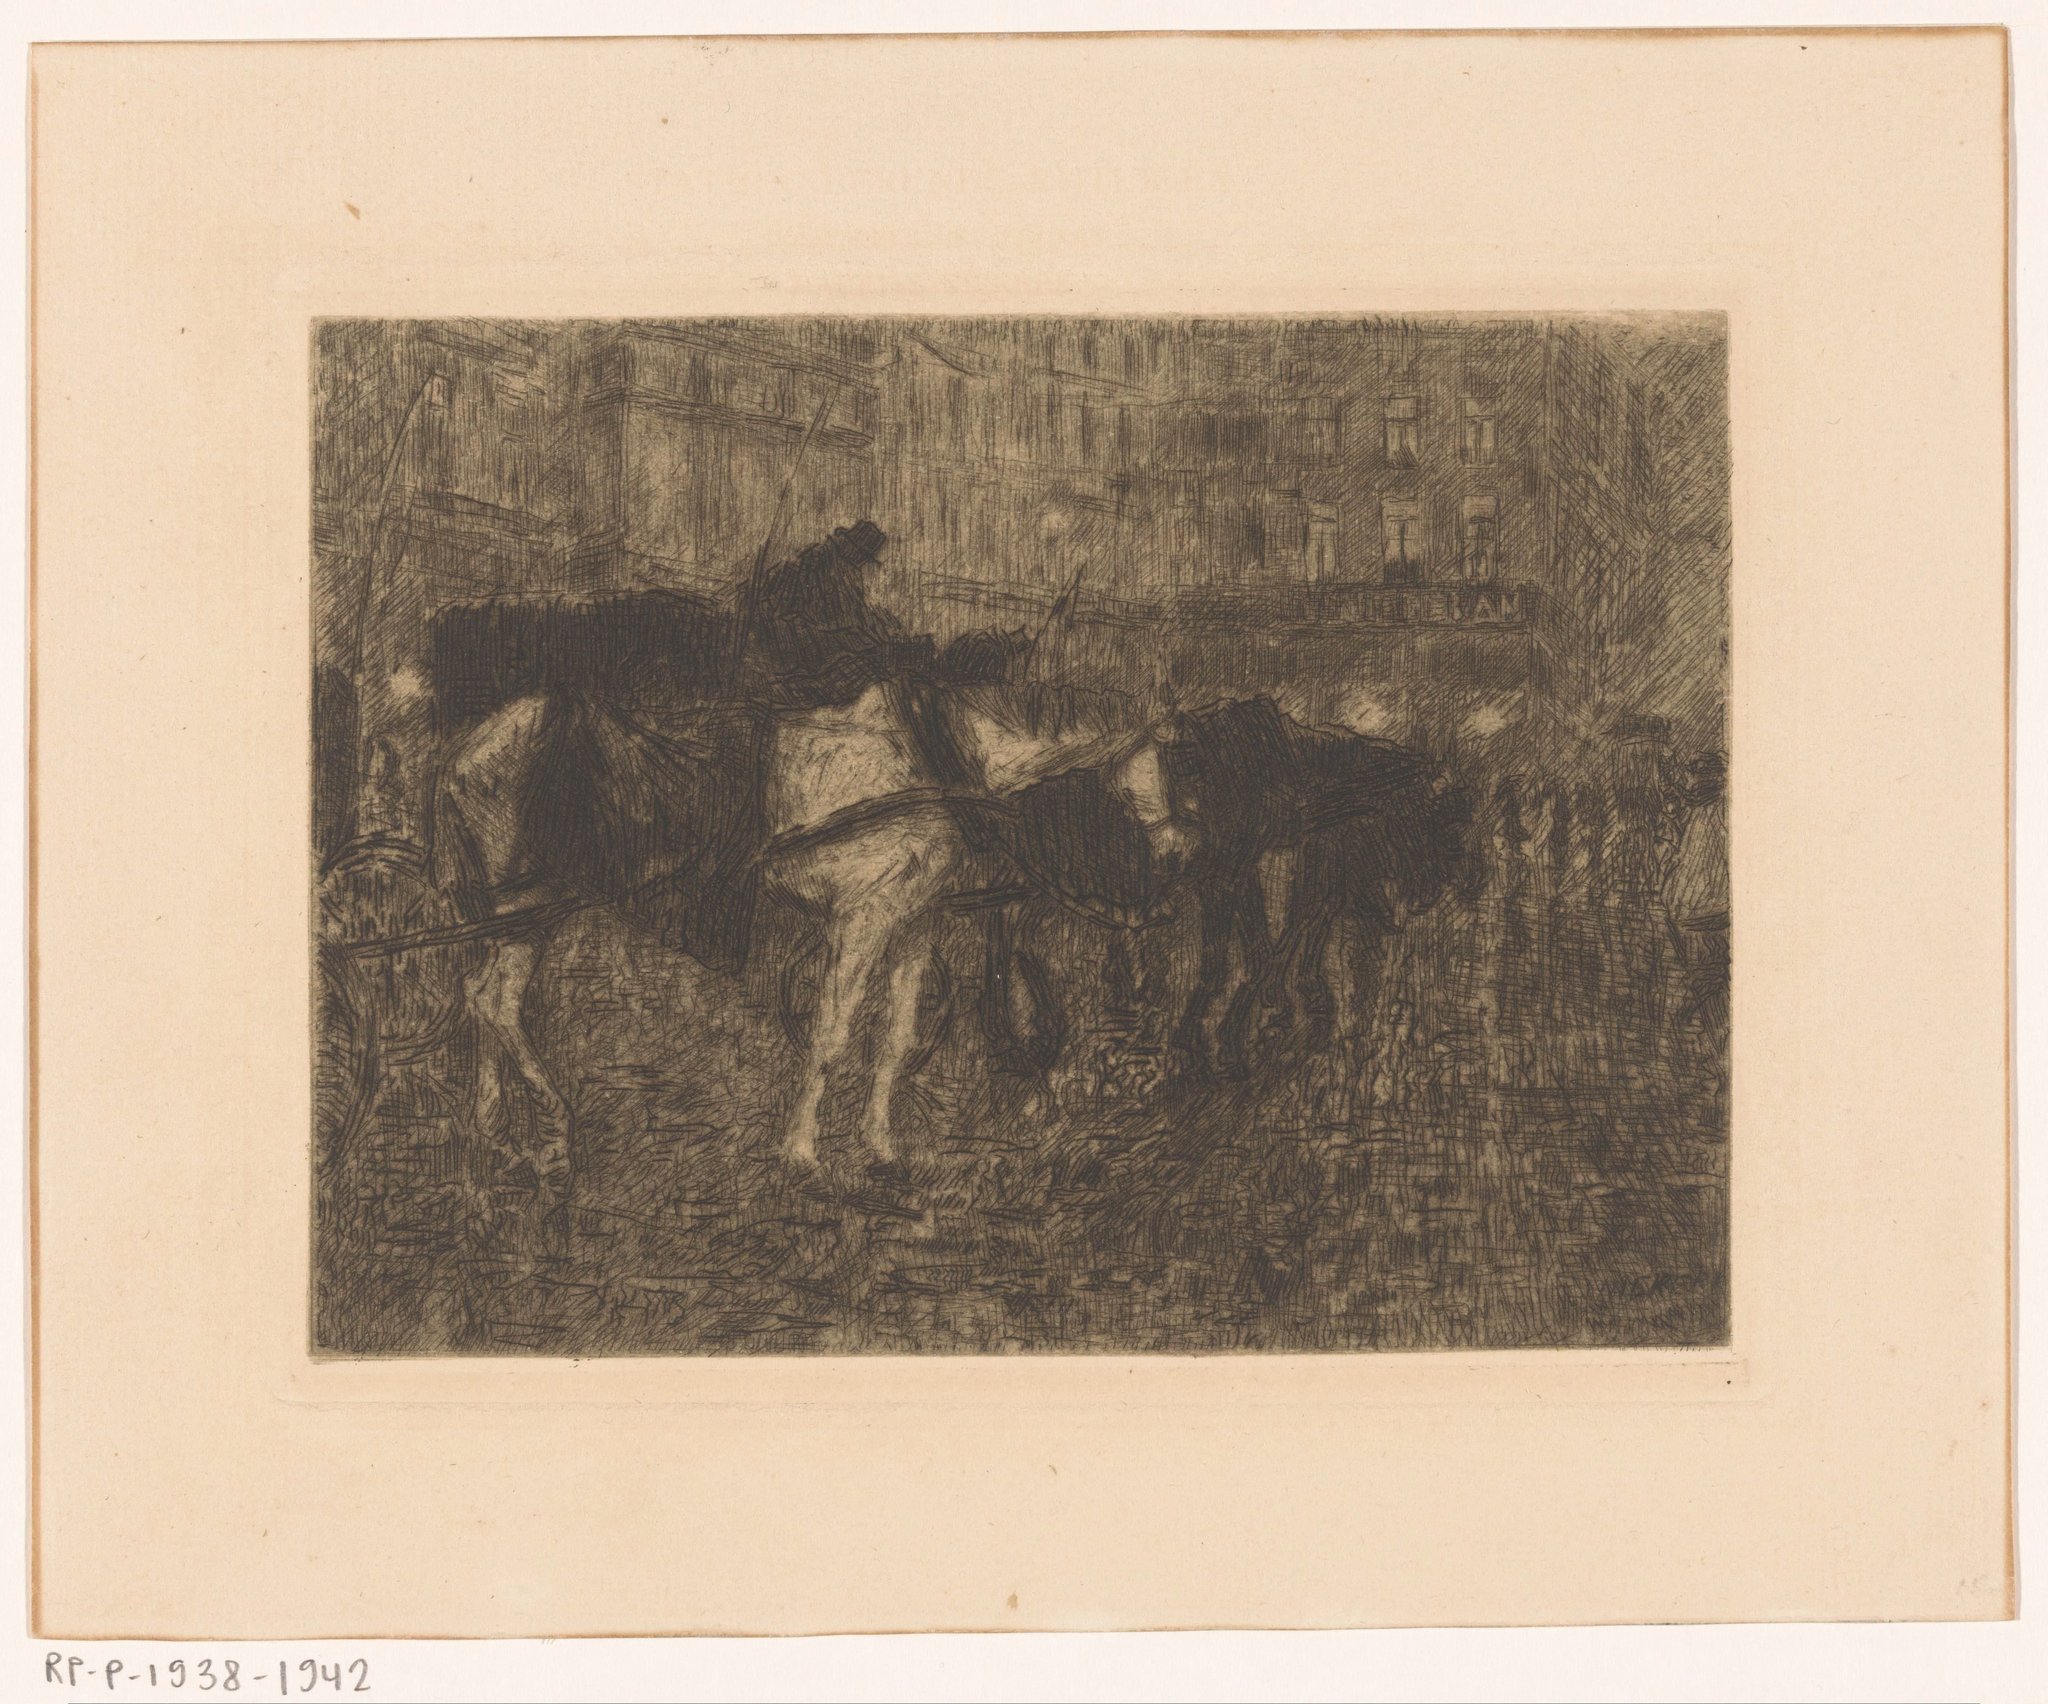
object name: print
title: Koetspaarden op een stadsplein bij avond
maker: maurits niekerk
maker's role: print maker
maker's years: 1871-1940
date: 1881-1938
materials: paper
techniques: etching, intaglio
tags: animal traction, animal-drawn vehicle (carriage etc.), evening, horse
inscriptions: collector's mark: Lugt 2760, collector's mark: Lugt 2228